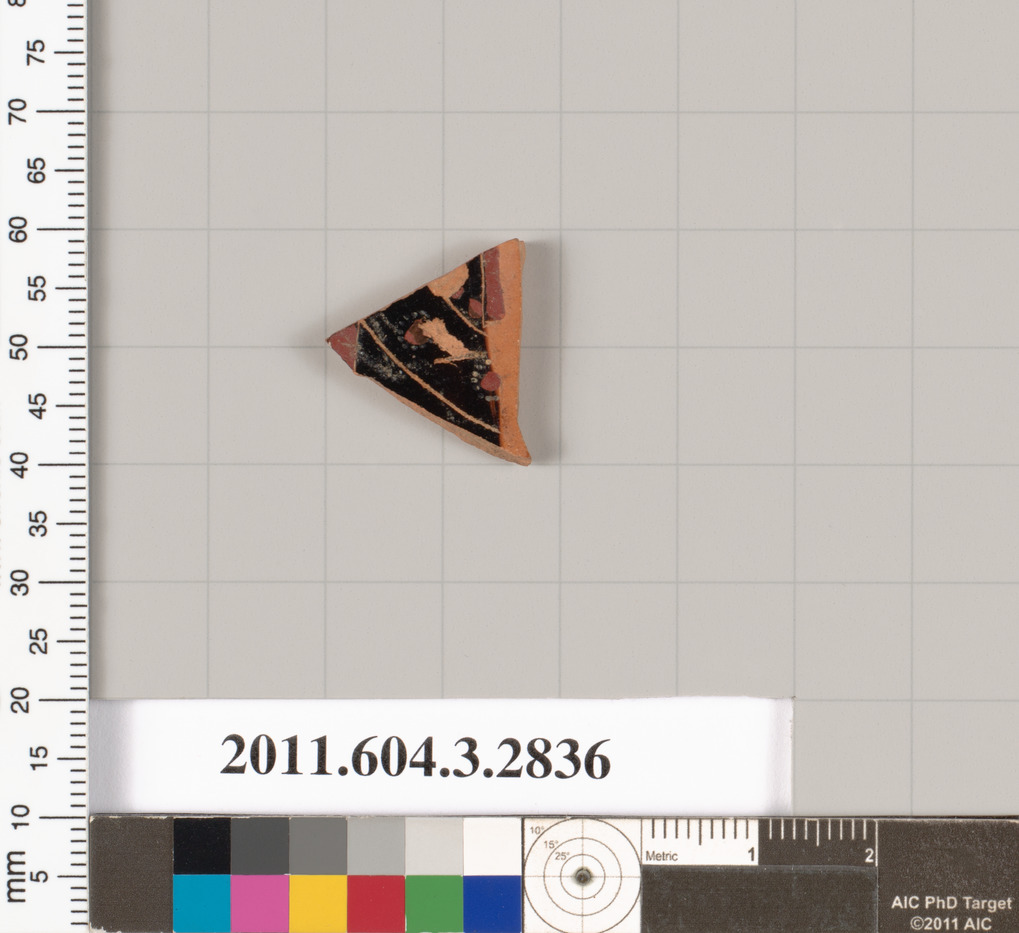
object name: undetermined closed shape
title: Terracotta fragment of a closed shape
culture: greek, attic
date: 534-468 BCE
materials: terracotta